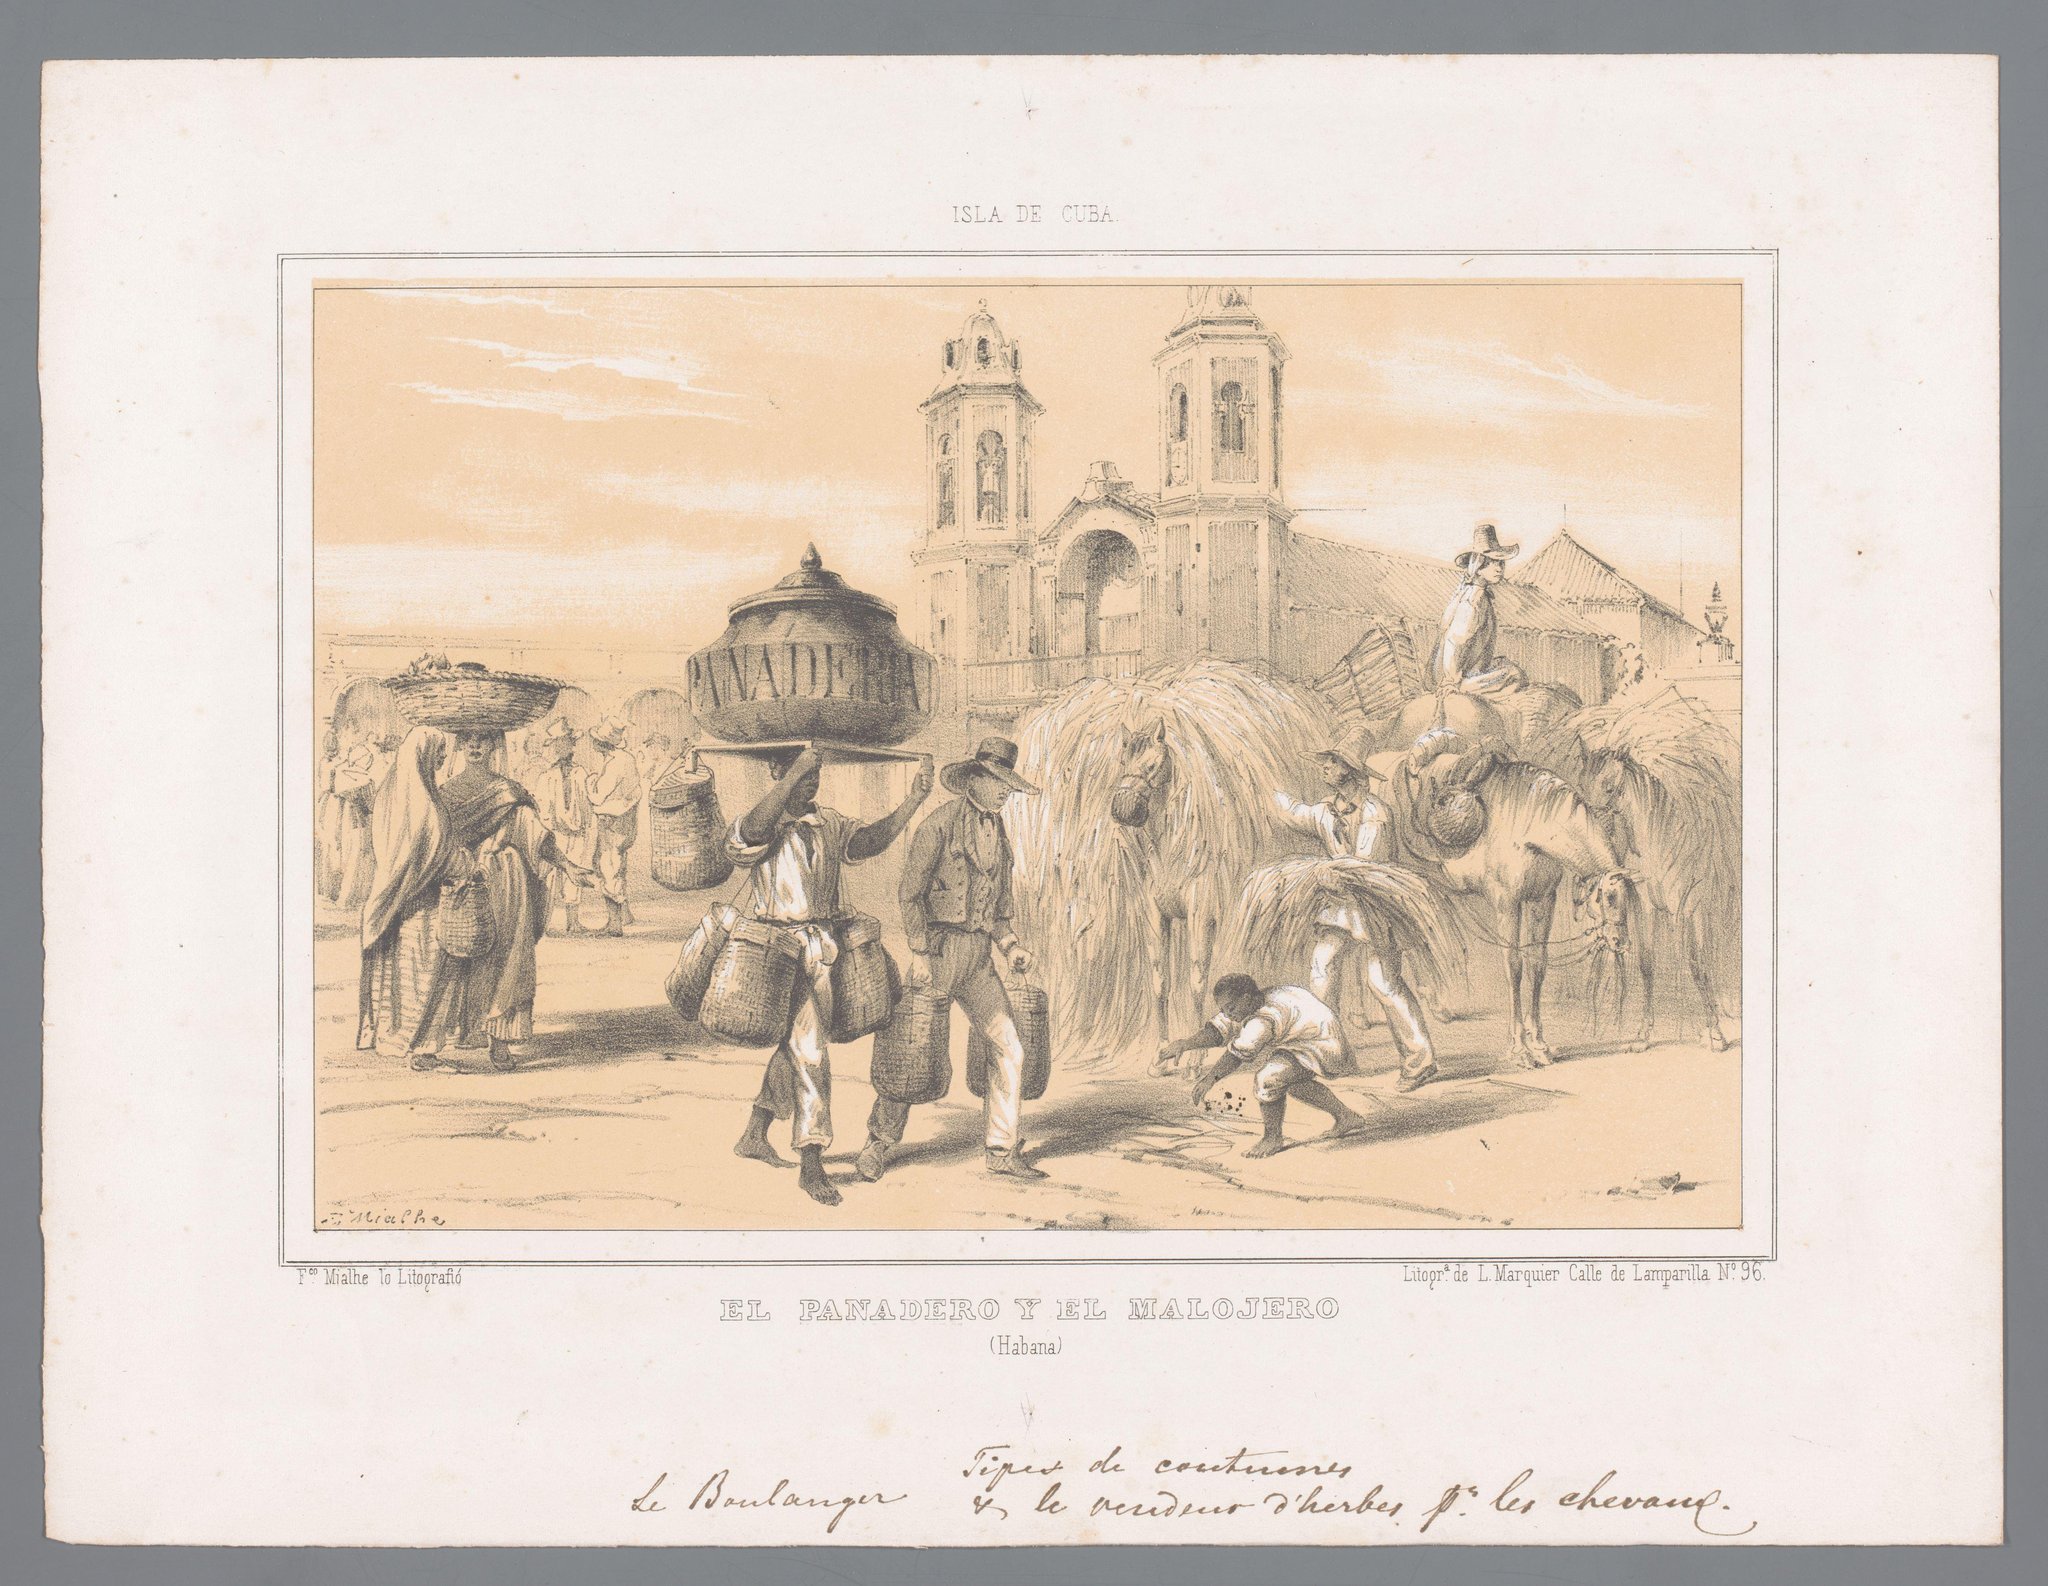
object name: print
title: El panadero y el malojero, Habana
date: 1848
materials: paper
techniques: tone lithography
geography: cuba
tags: agricultural products and by-products: hay, church (exterior), baker, market, trade, commerce and finance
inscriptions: collector's mark: Lugt 2228